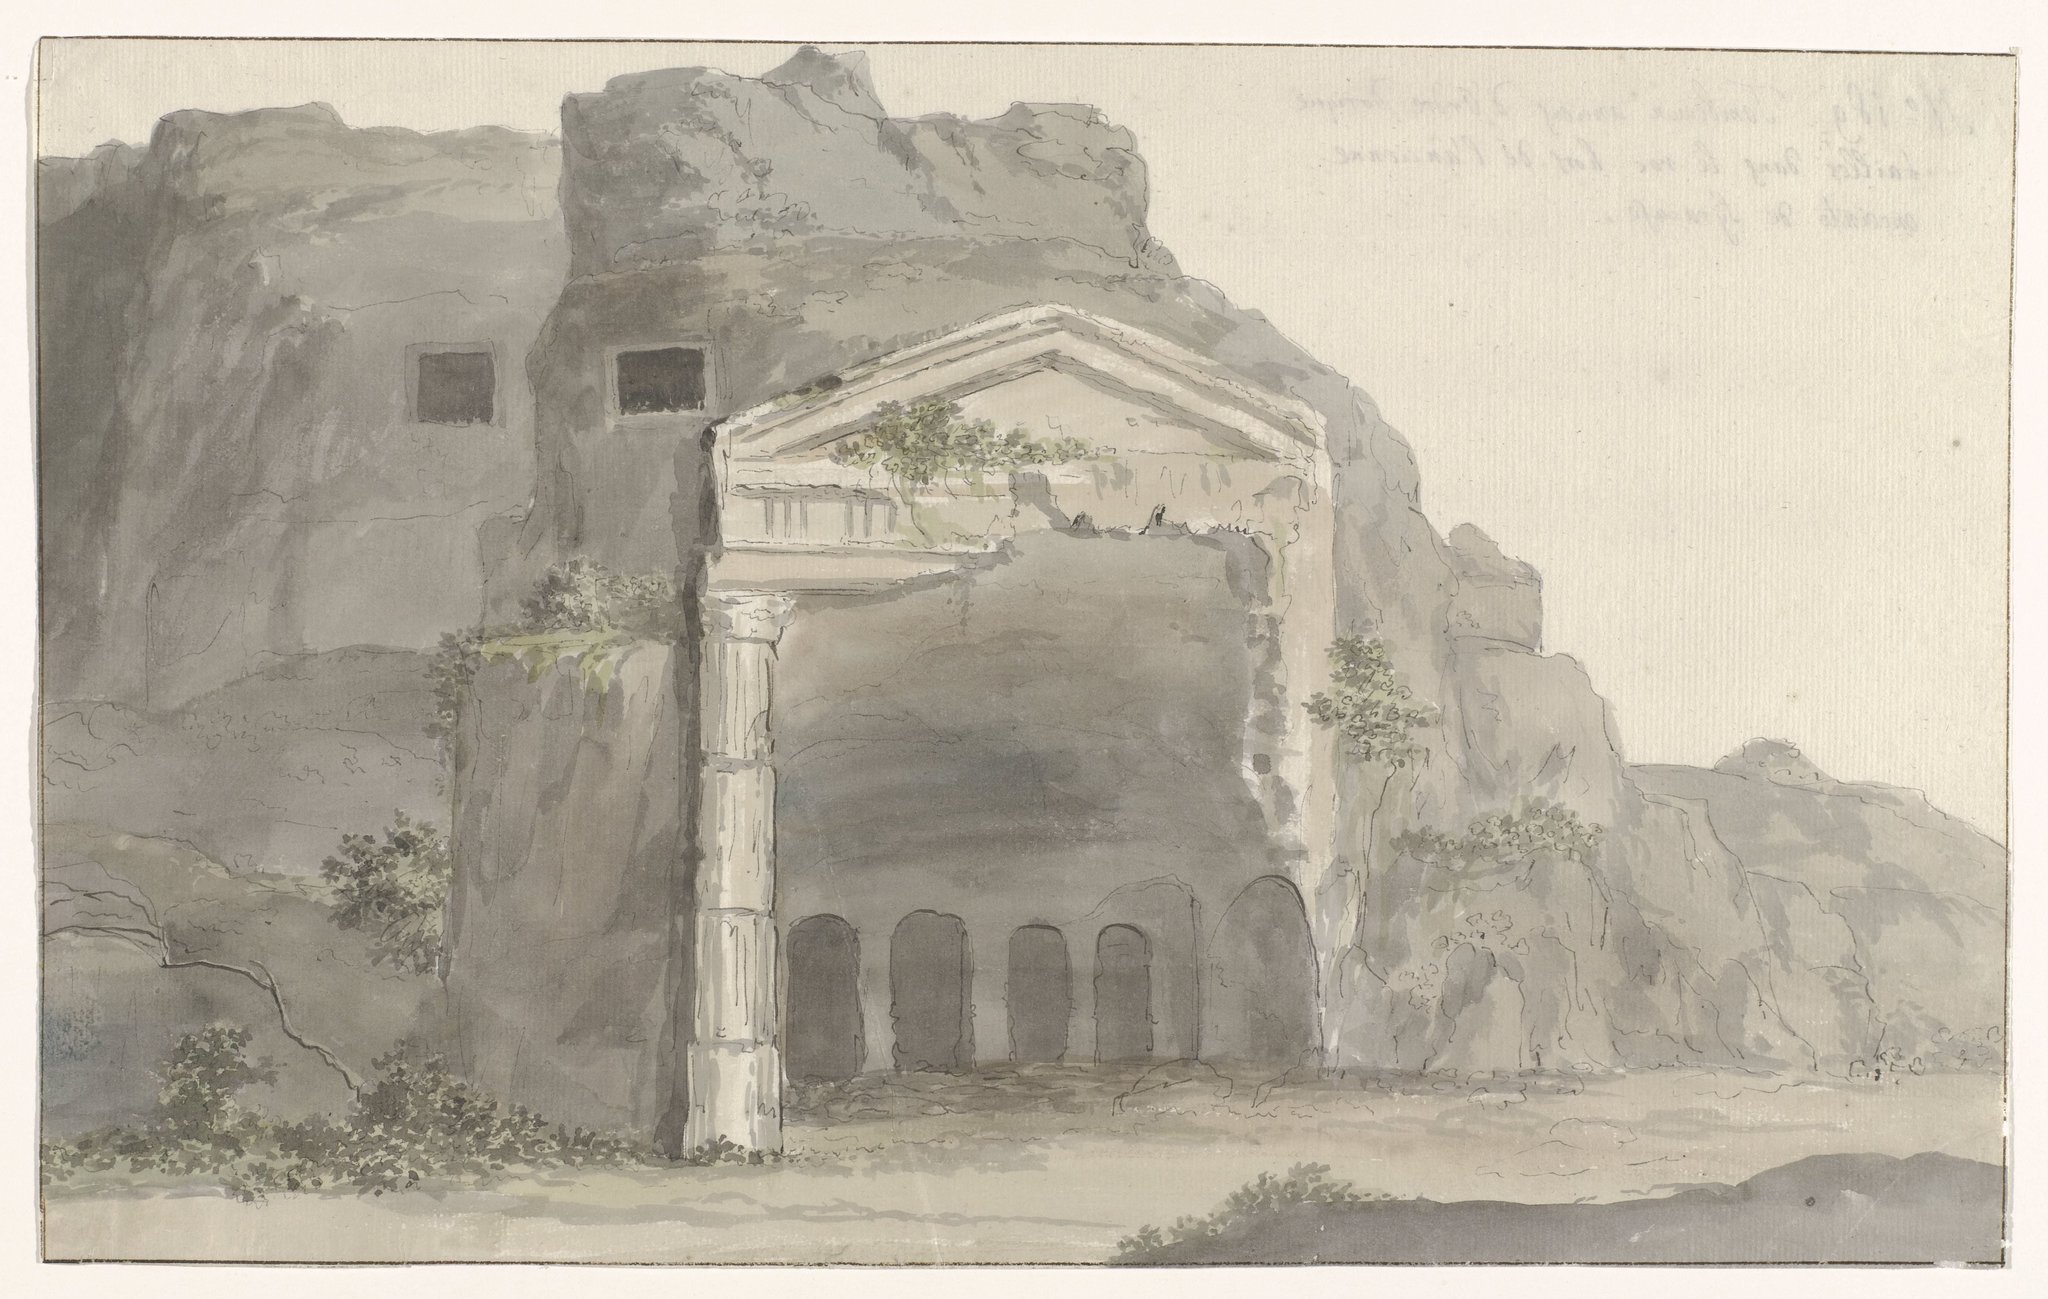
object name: drawing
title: Voyage en Italie, en Sicile et à Malte - 1778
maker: louis ducros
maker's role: draughtsman, print maker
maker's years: 1748-1810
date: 1778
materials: chalk, paper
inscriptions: inscription: ‘No 189 Tombes ... de Syracuse’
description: Onduidelijk wat inhoud van opschrift op verso is, tekening reeds opgezet.